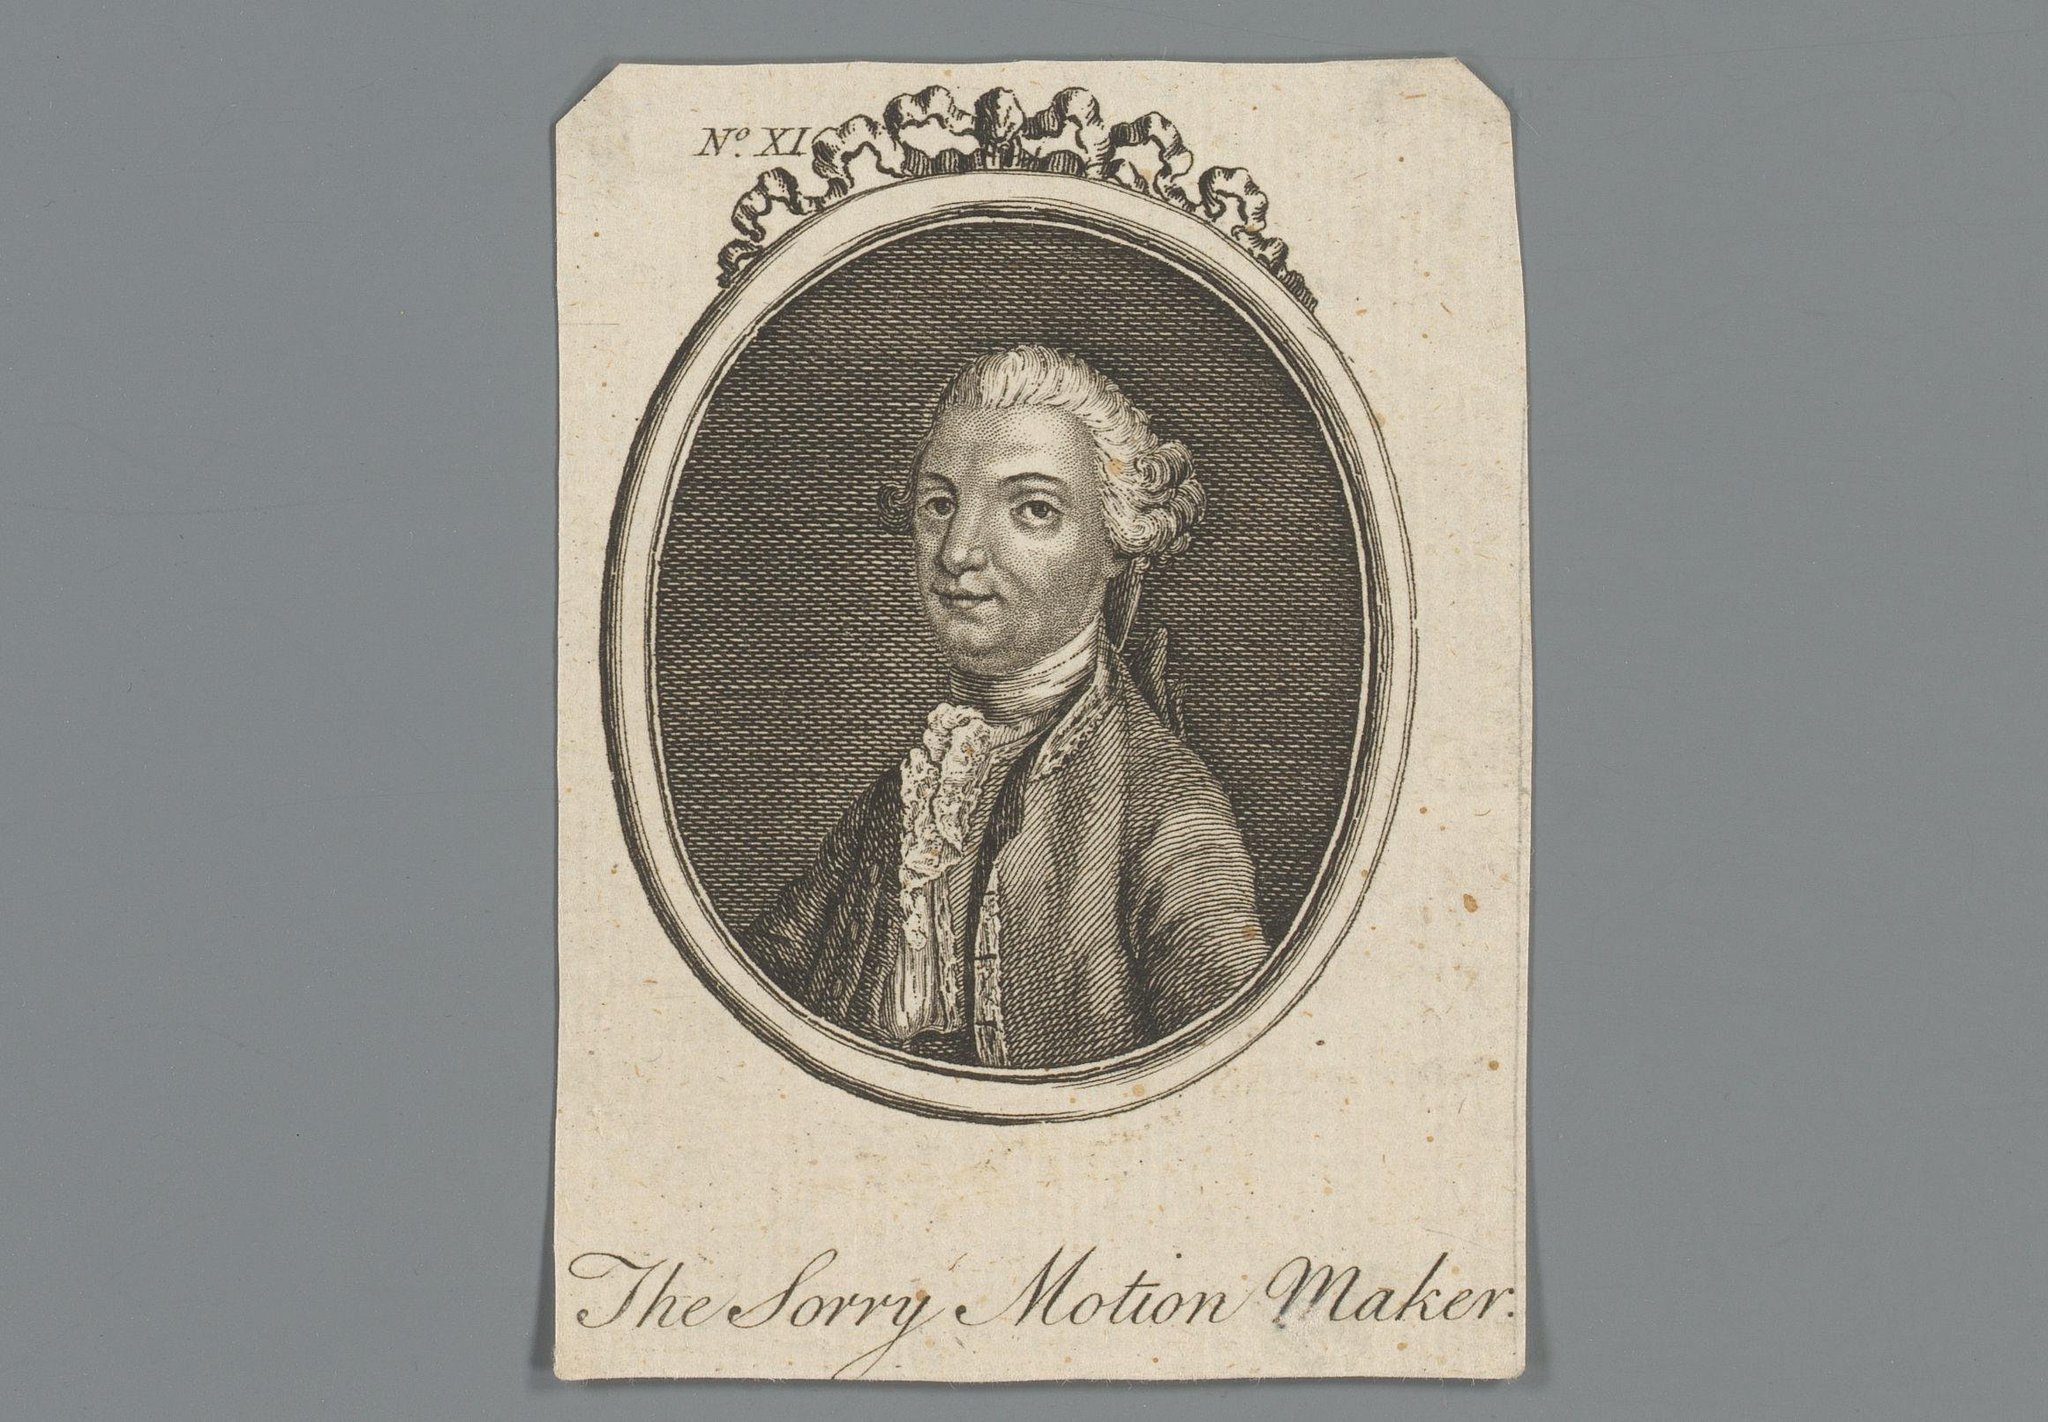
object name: print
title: Portret van een onbekende man met een pruik als "The Sorry Motion Maker"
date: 1771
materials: paper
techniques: etching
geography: london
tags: wig, historical persons not known by name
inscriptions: collector's mark: Lugt 2228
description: Prent waarschijnlijk uit: Town and Country Magazine 3 (1771), april 1771.